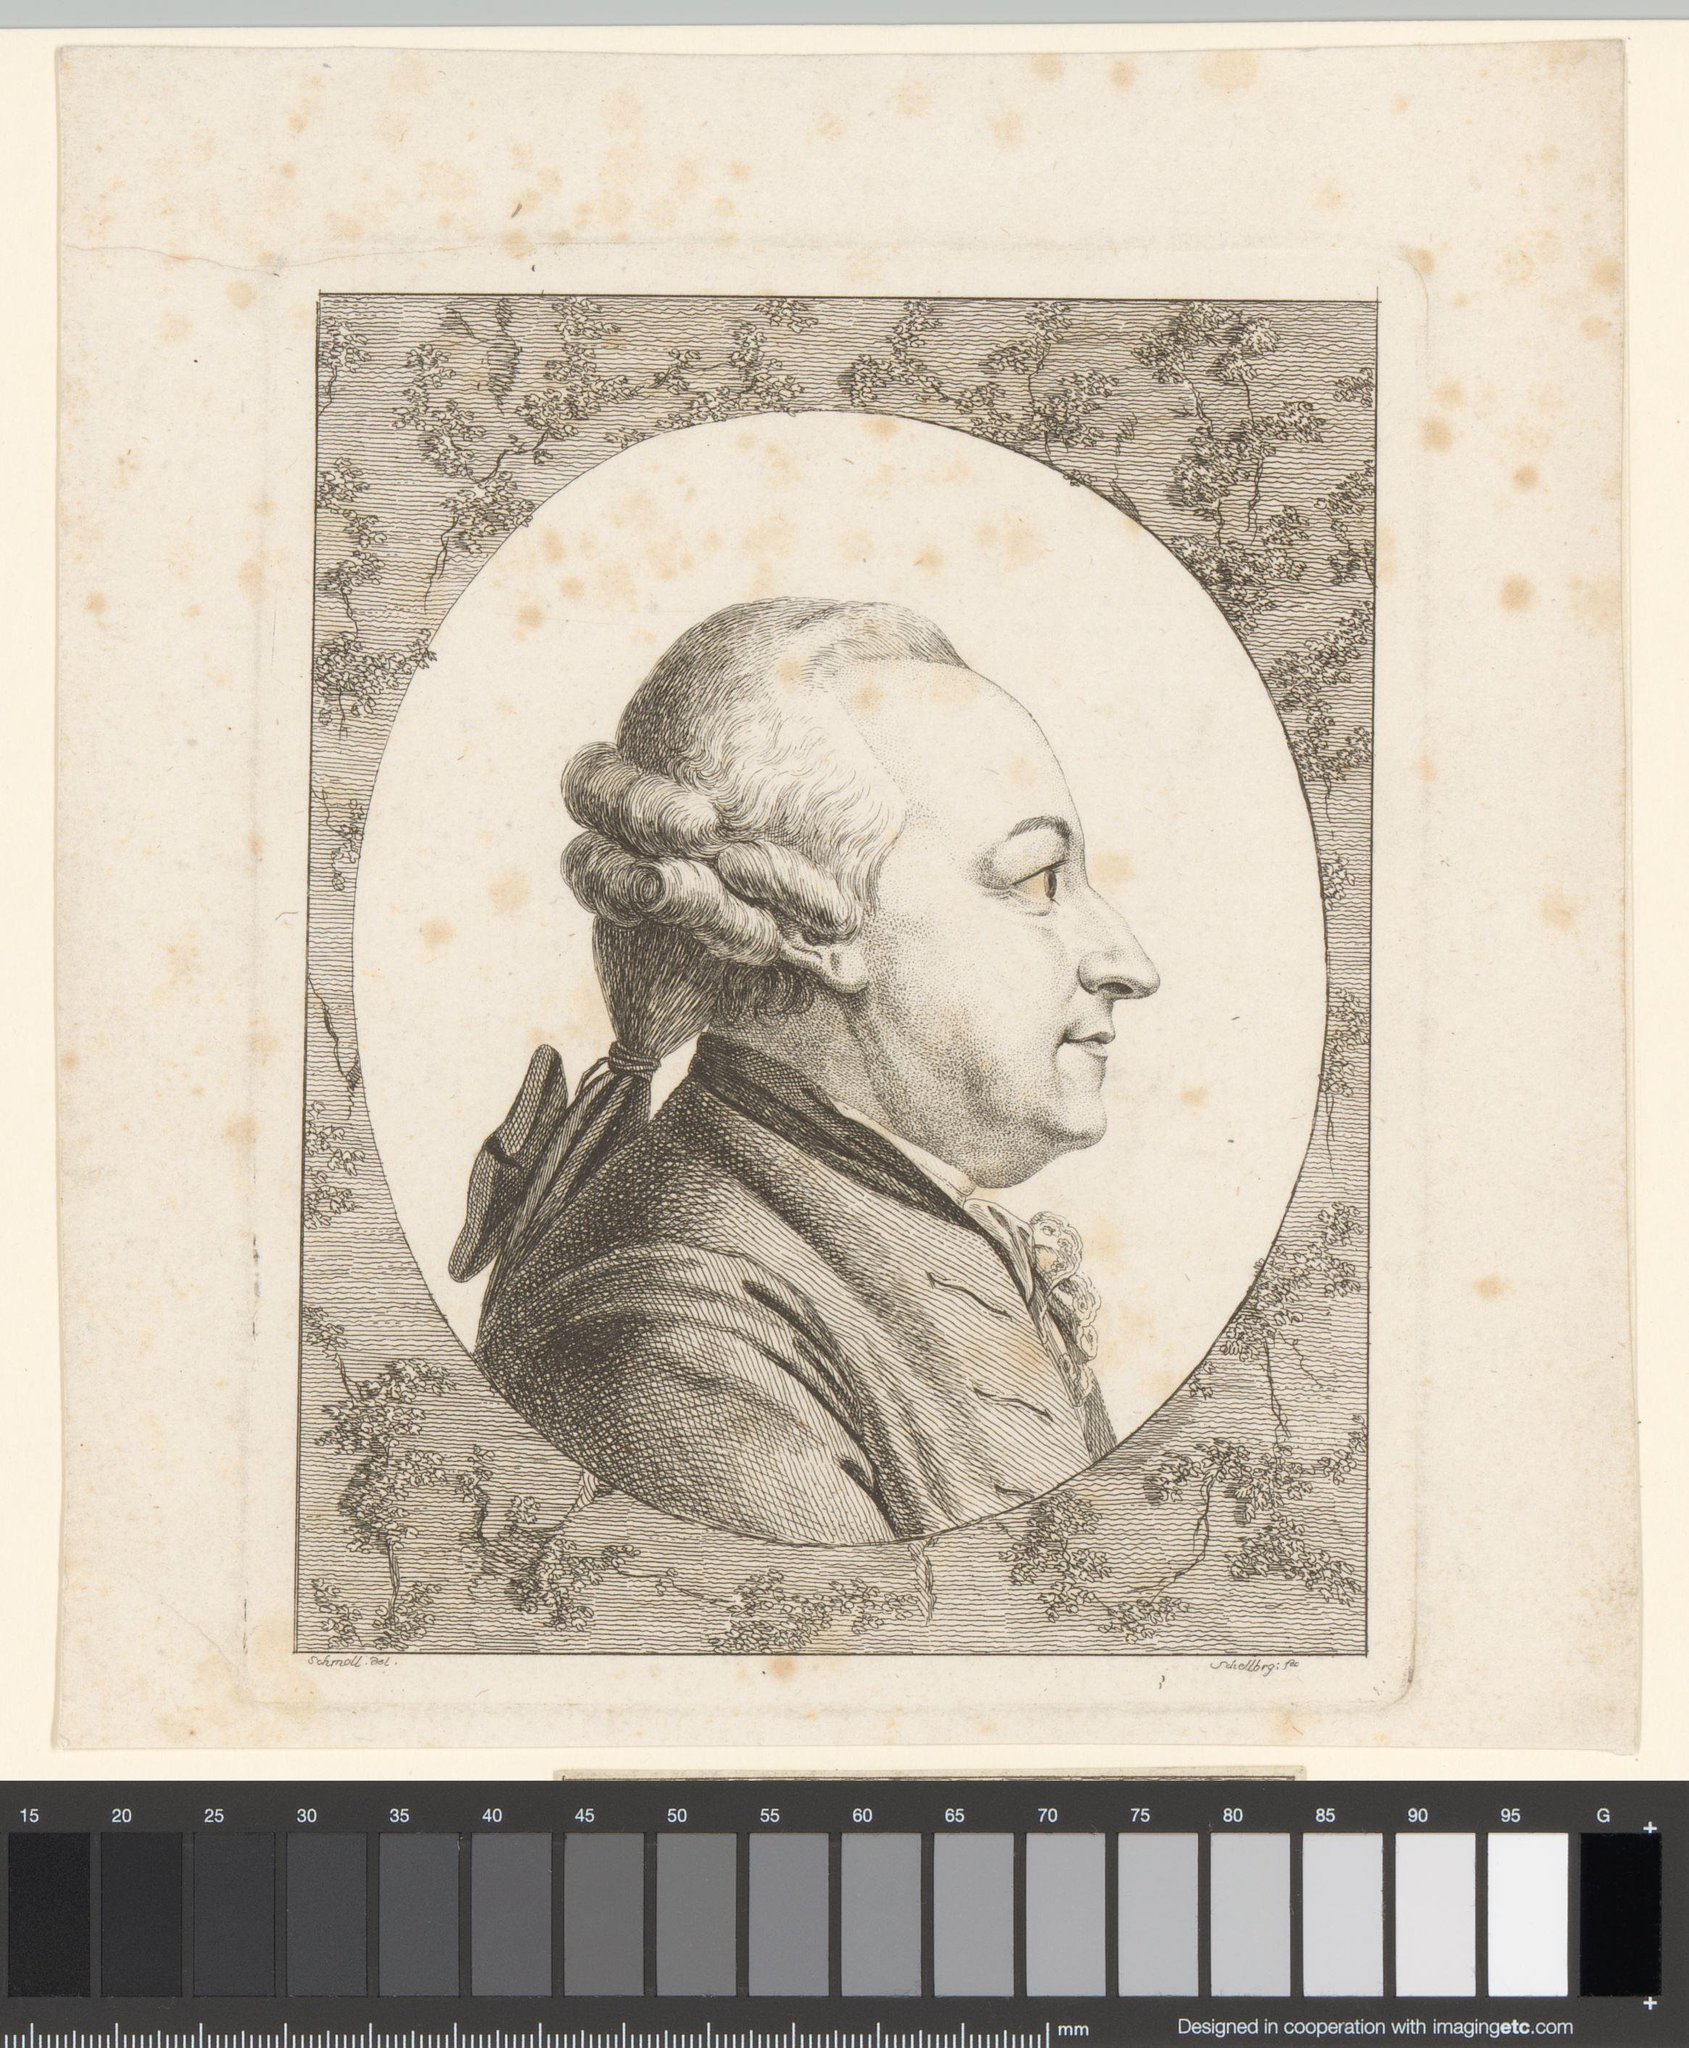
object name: print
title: Portret van Johann Konrad Pfenninger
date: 1784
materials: paper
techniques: etching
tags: historical persons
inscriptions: collector's mark: Lugt 2228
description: Prent ook gebruikt in: Stoy, Johann Sigmund. Bilder-Akademie für die Jugend. Neurenberg: Johann Sigmund Stoy, 1784.